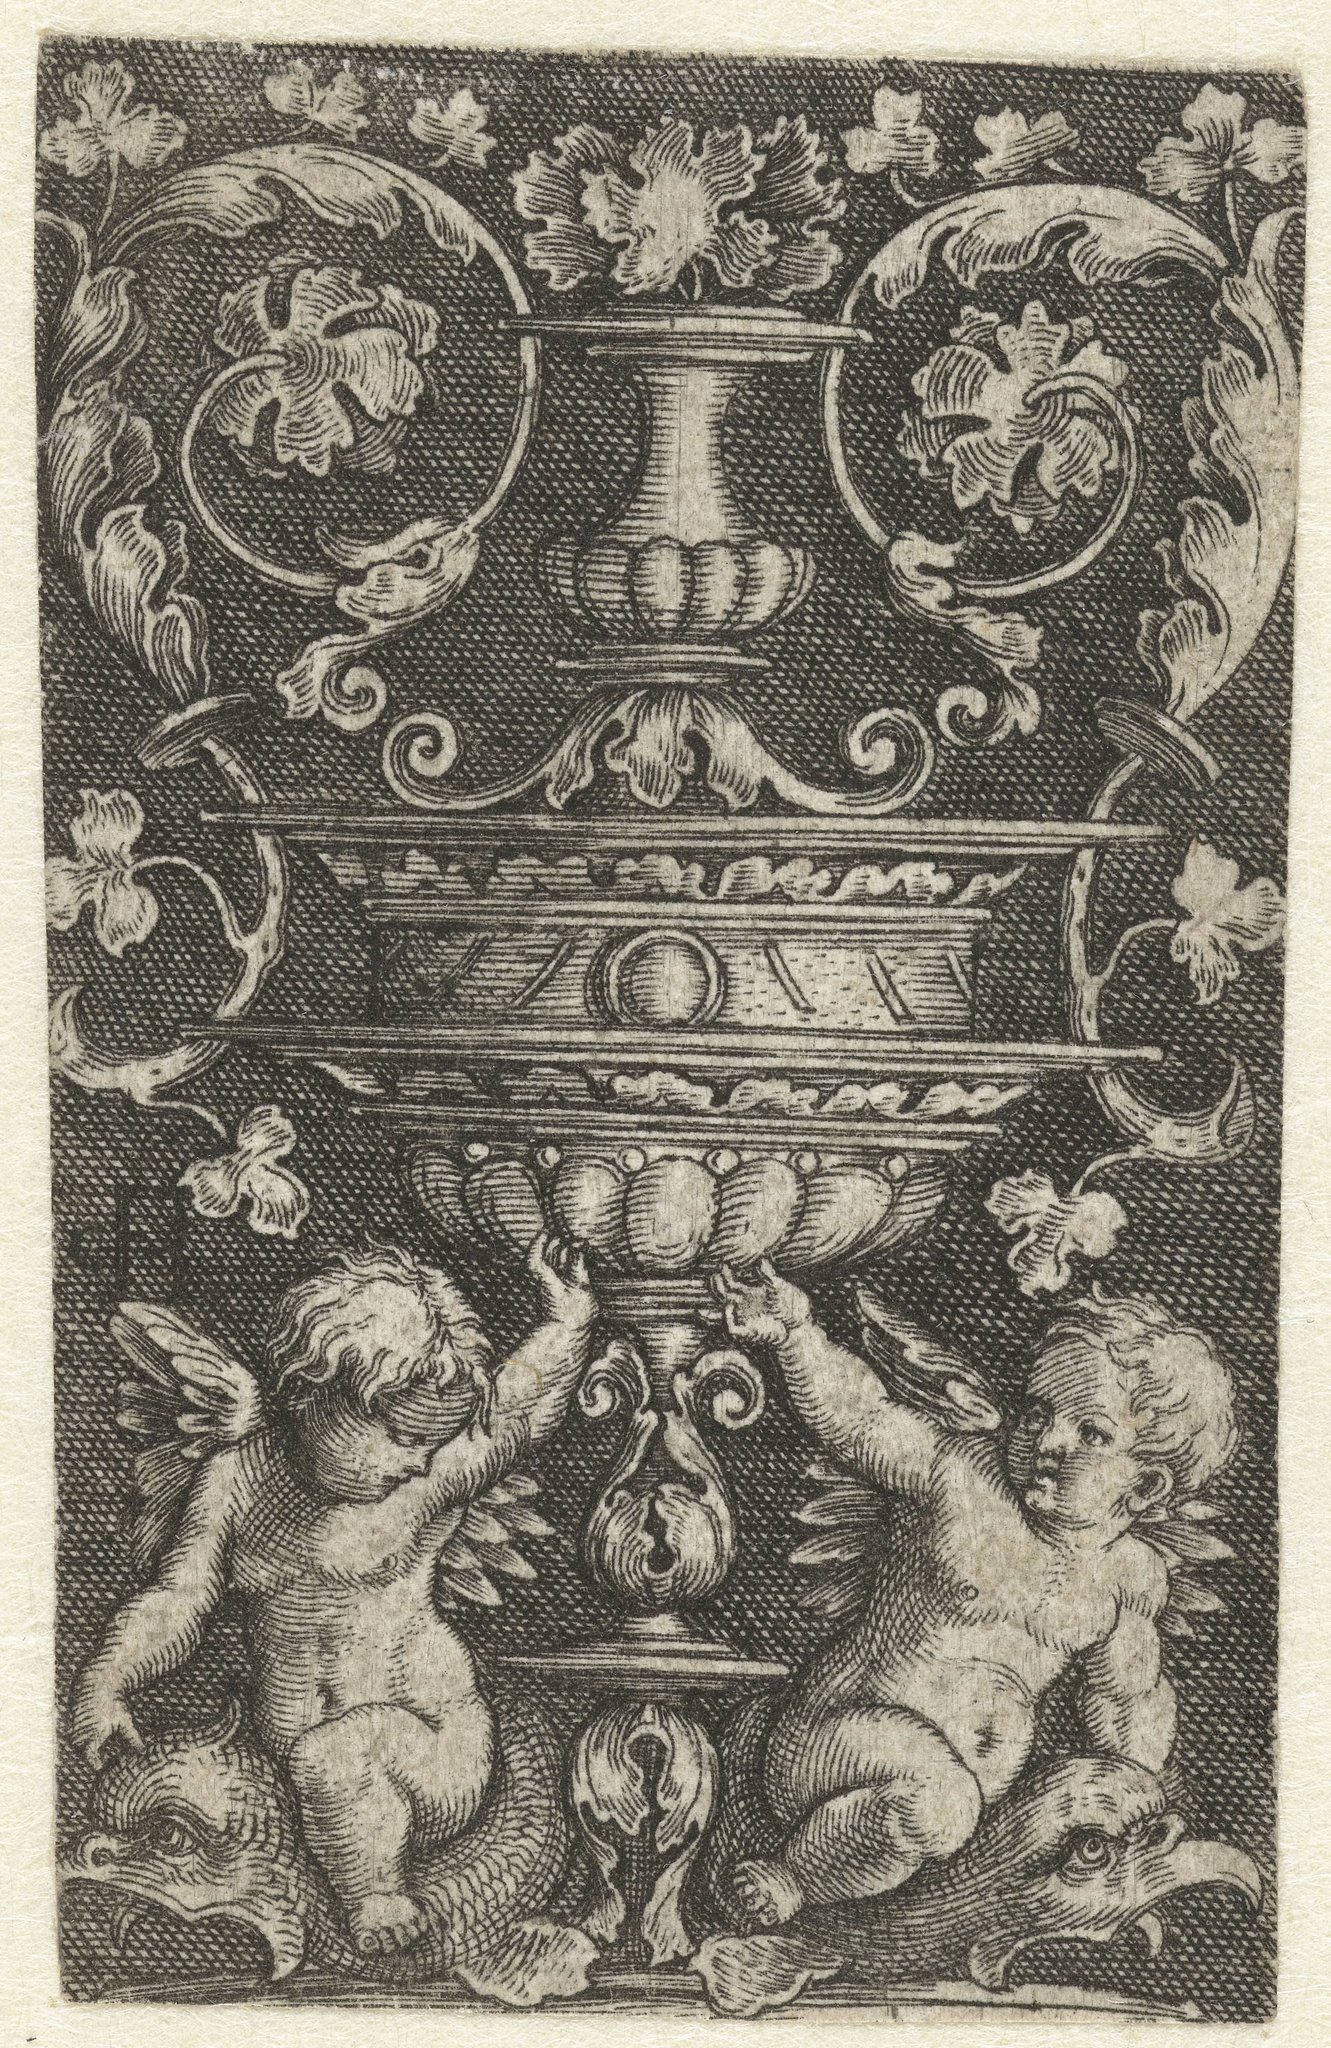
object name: print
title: Ornament met twee putti op dolfijnen onder een vaas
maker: jacob binck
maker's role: painter, print maker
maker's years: 1494-1569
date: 1510-1569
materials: paper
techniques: engraving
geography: germany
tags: ornament ~ candelabrum, cupids: 'amores', 'amoretti', 'putti'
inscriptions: collector's mark: Lugt 2773, collector's mark: Lugt 2233